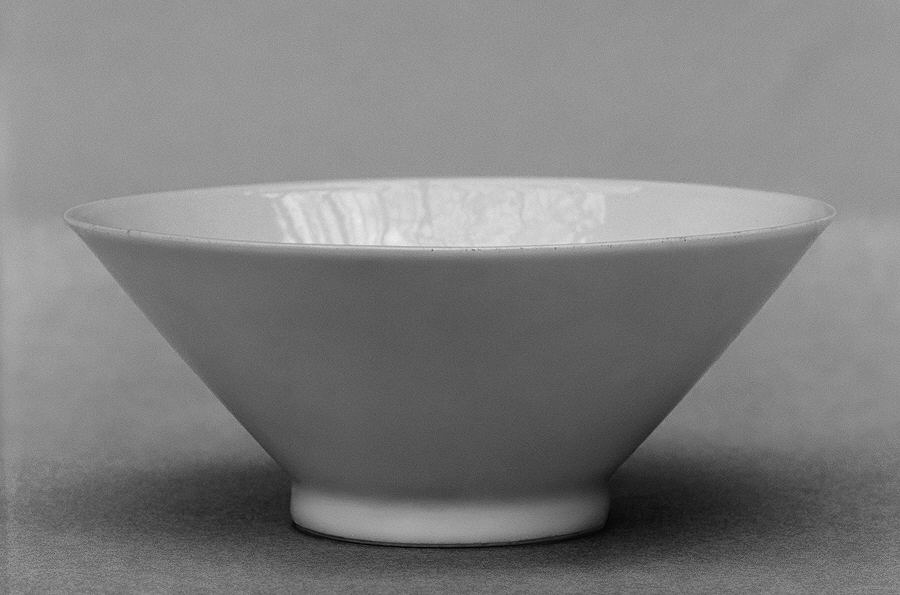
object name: bowl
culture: chinese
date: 1488-1505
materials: porcelain